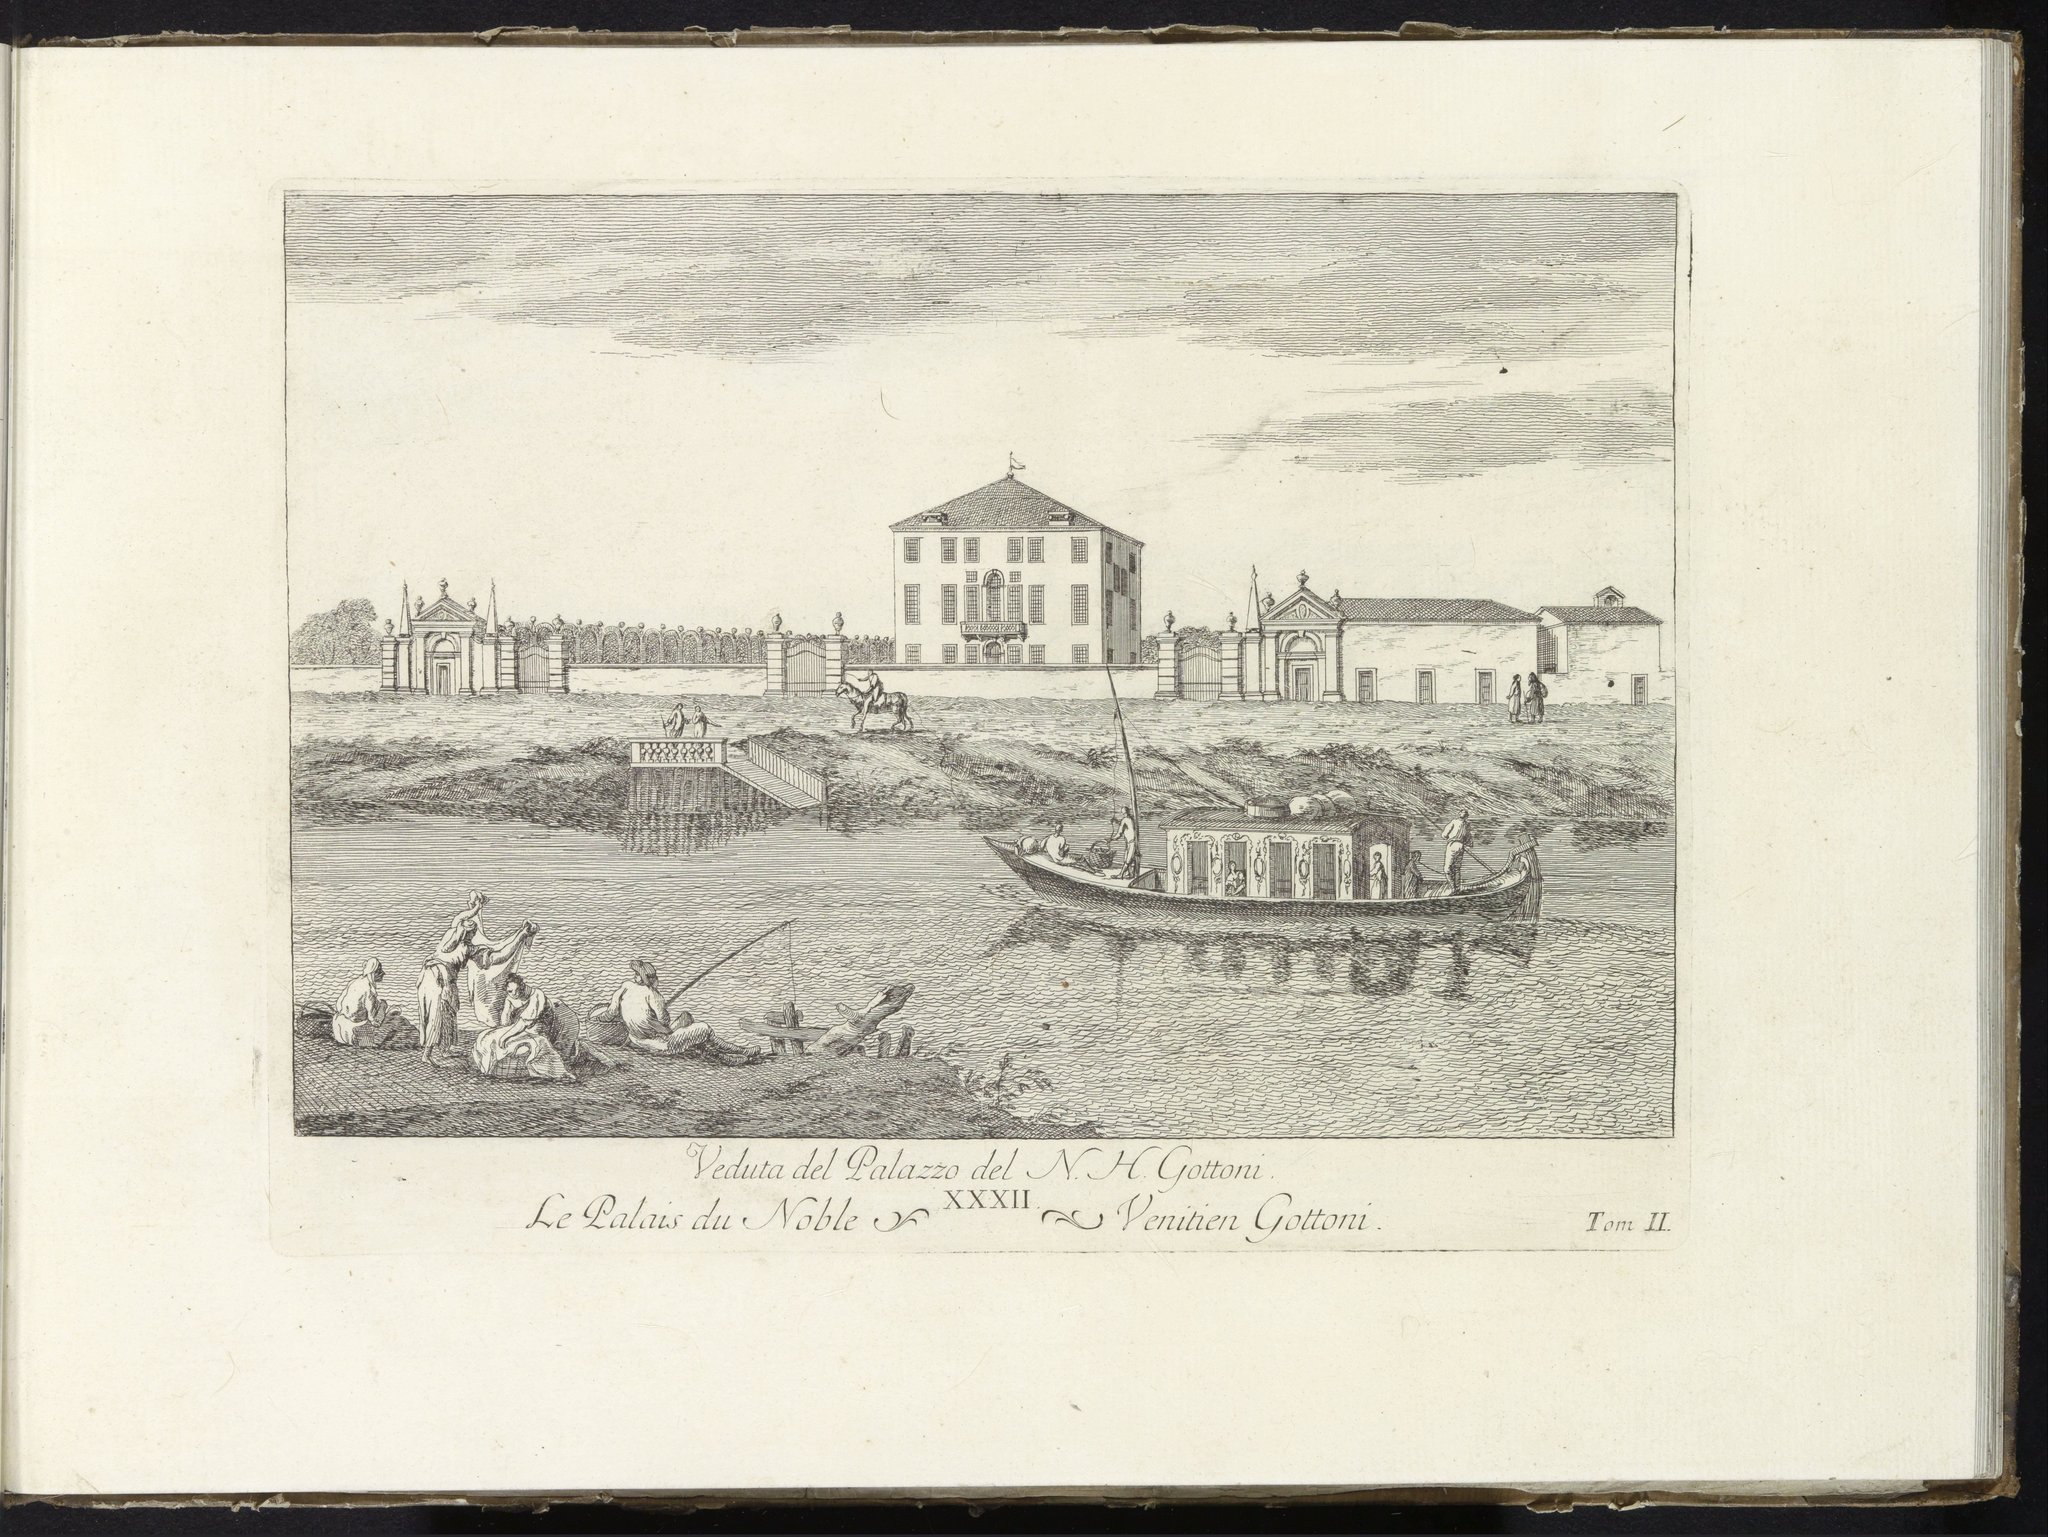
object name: print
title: Le delicie della Brenta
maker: giovanni francesco costa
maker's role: draughtsman, painter, print maker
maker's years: -1773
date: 1750-1760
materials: paper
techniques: etching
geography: venice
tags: river, tow-boat, towing-barge, hôtel, i.e. small palace in city, fisherman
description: Gezicht op Palazzo del N. H. Gottoni aan de rivier de Brenta. Op het water vaart een trekschuit. Op de voorgrond zitten een visser en wasvrouwen aan de waterkant. Genummerd midden onder: VIII en rechtsonder: Tom: II. Deze prent maakt deel uit van een album.